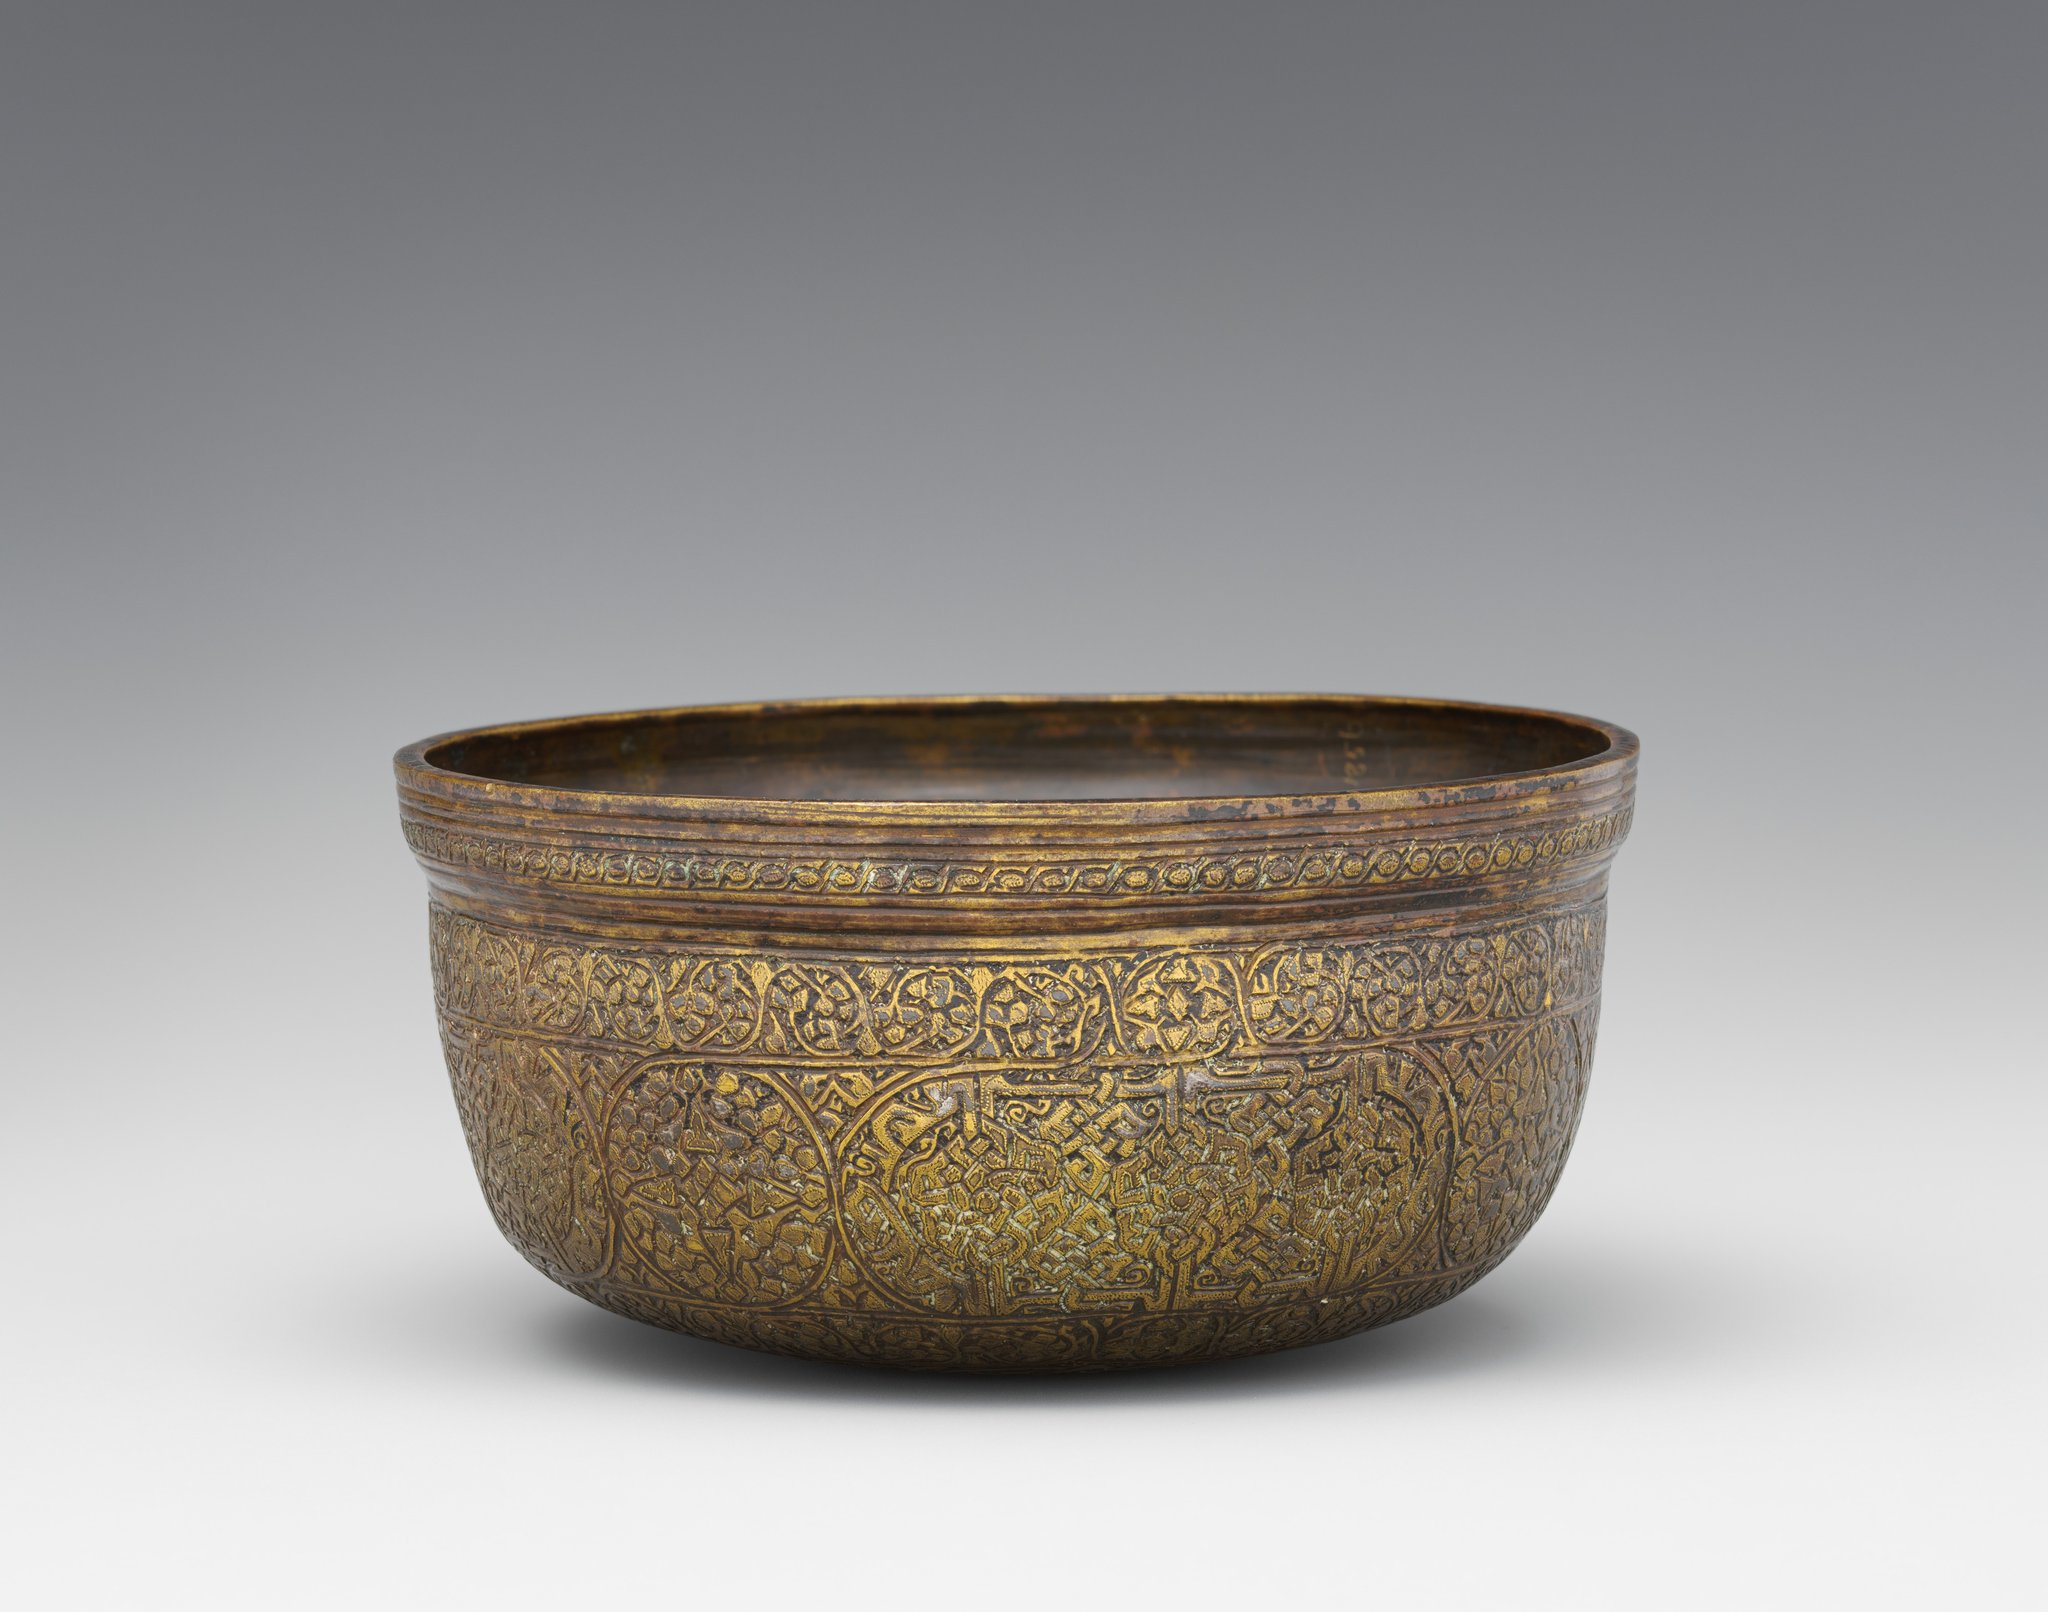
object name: bowl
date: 1401-1500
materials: brass, silver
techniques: inlay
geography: afghanistan